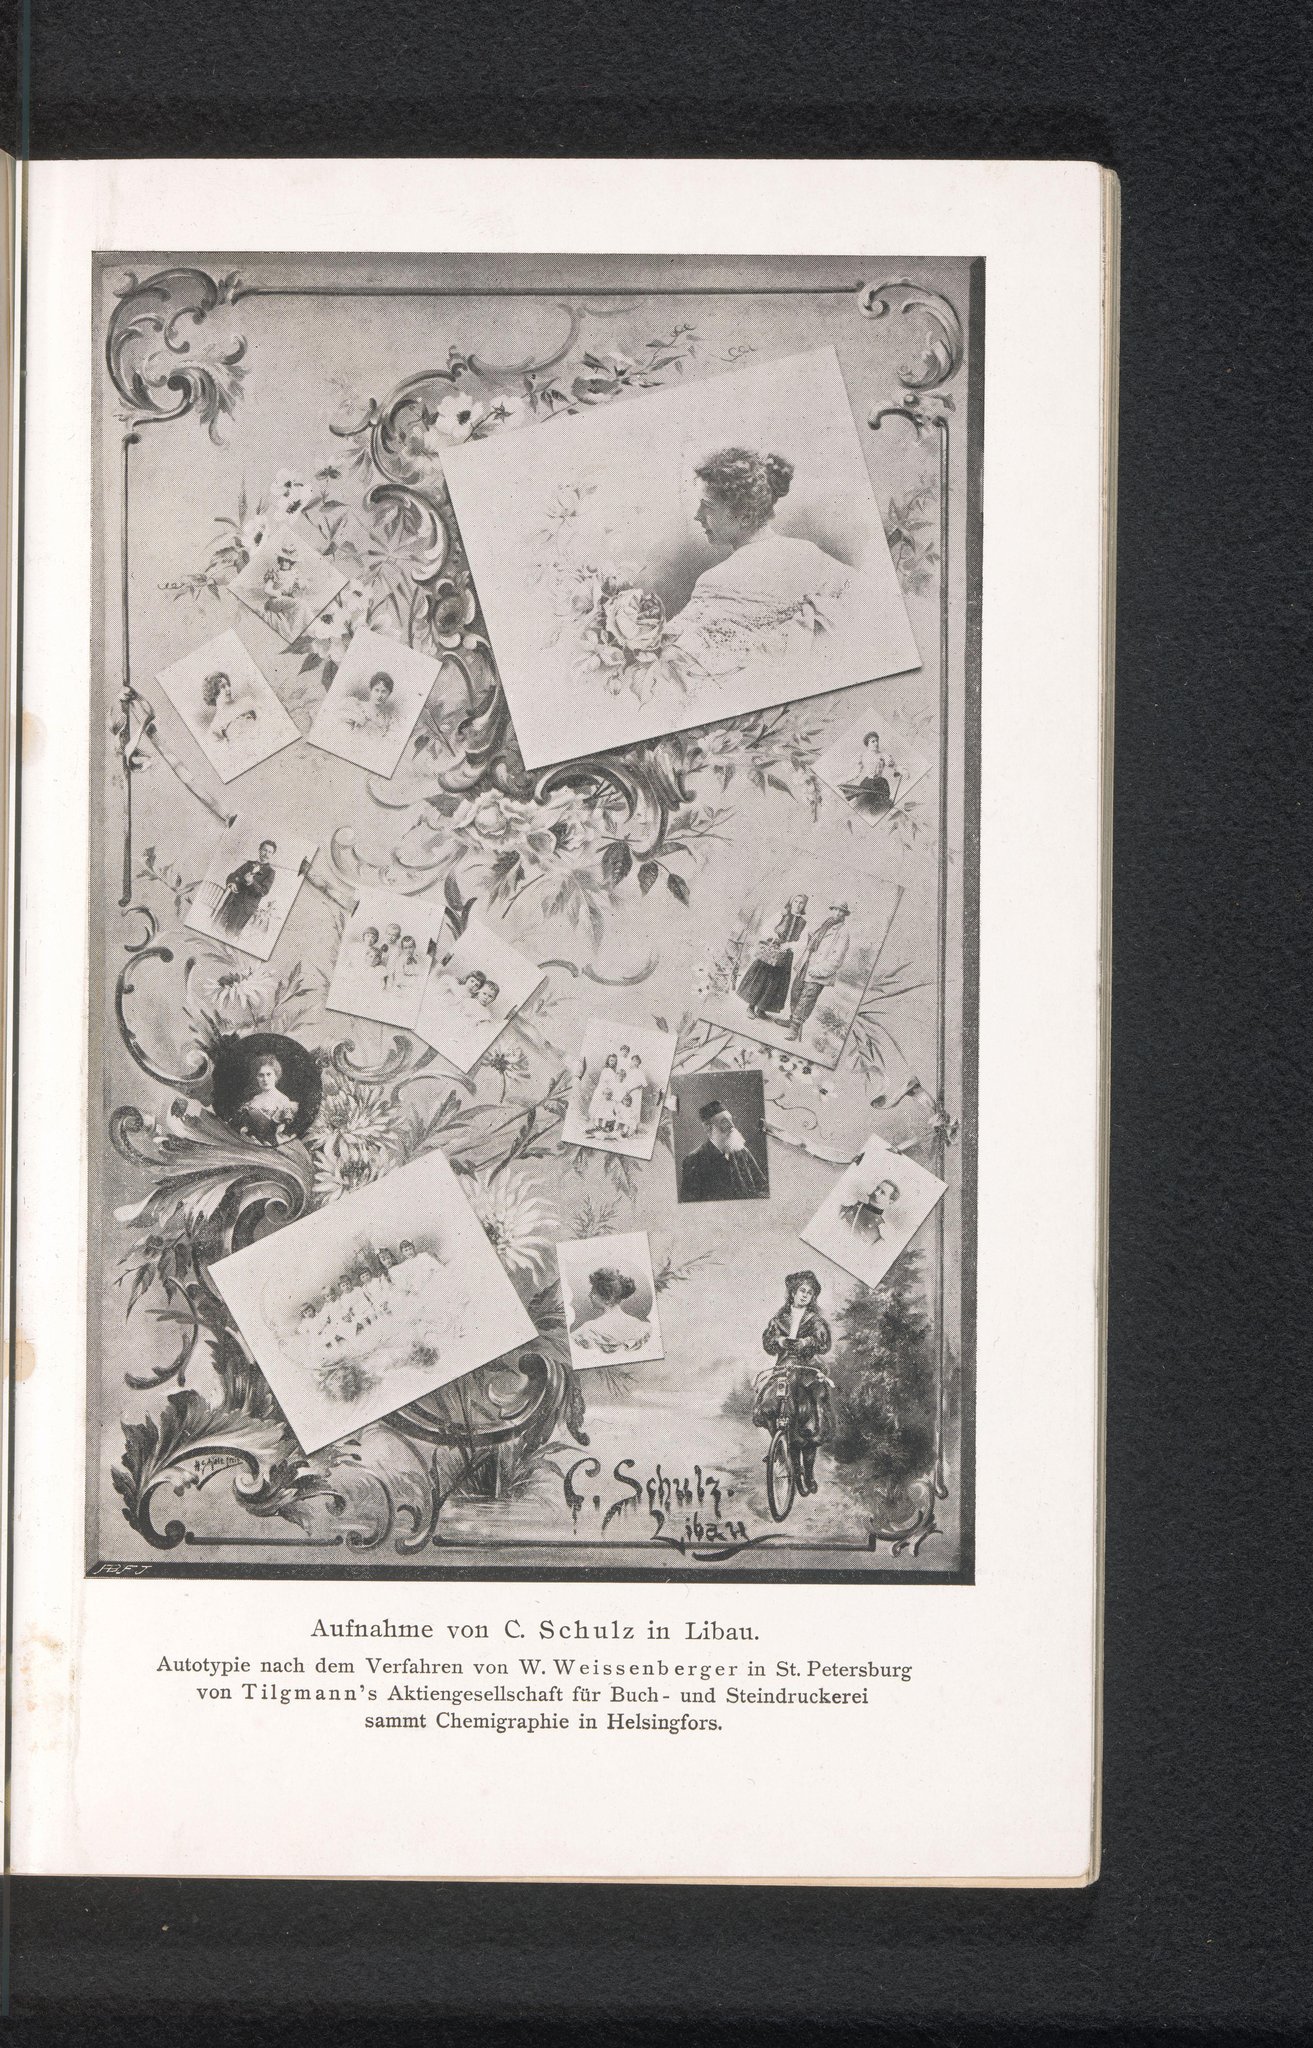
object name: photomechanical print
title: Reproductie van een fotocollage met verschillende portretten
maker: carl anton schulz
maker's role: fotograaf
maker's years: 1831-1884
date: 1894-1899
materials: paper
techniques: autotype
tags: photograph, historical persons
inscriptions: inscription: ‘Autotypie nach dem Verfahren von W. Weissenberger in St. Petersburg/ von Tilgmann's Aktiengeschaft für Buch- und Steindruckerei/ sammt Chemiegraphie in Helsingfors.’